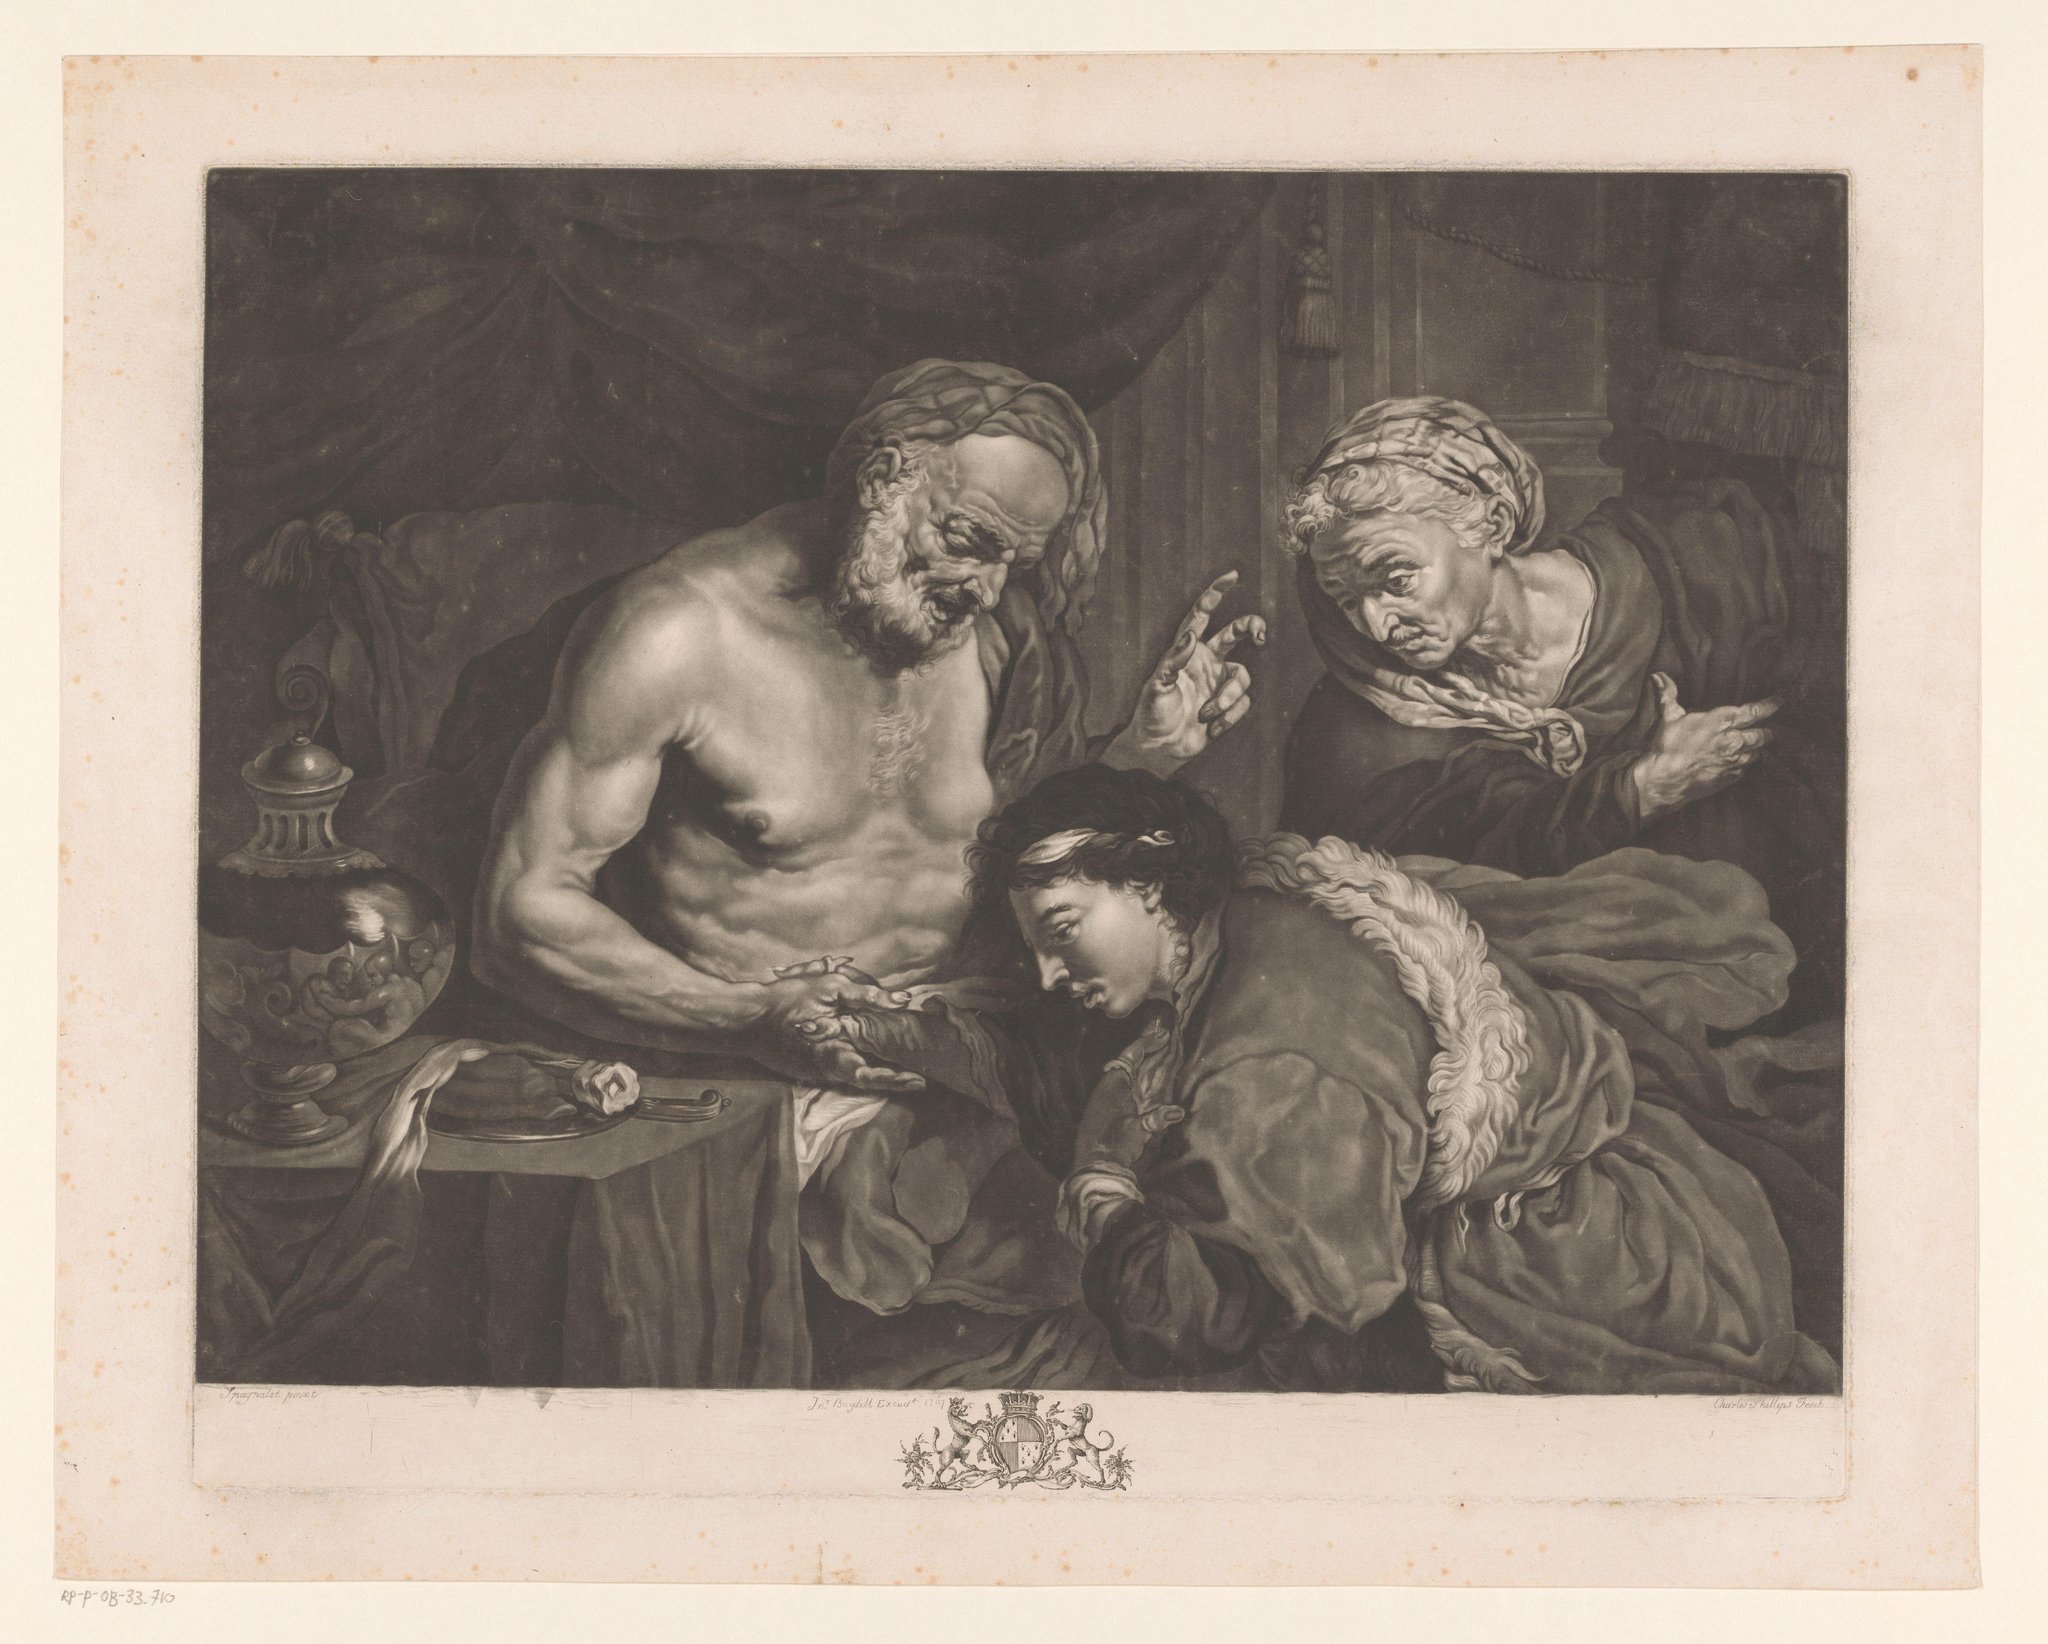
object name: print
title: Isaak zegent Jakob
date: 1767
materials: paper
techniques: mezzotint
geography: london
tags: isaac lying in bed blesses jacob who, disguised in esau's clothes, brings food to his father; jacob's hands and neck are covered with goatskins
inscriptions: collector's mark: Lugt 240